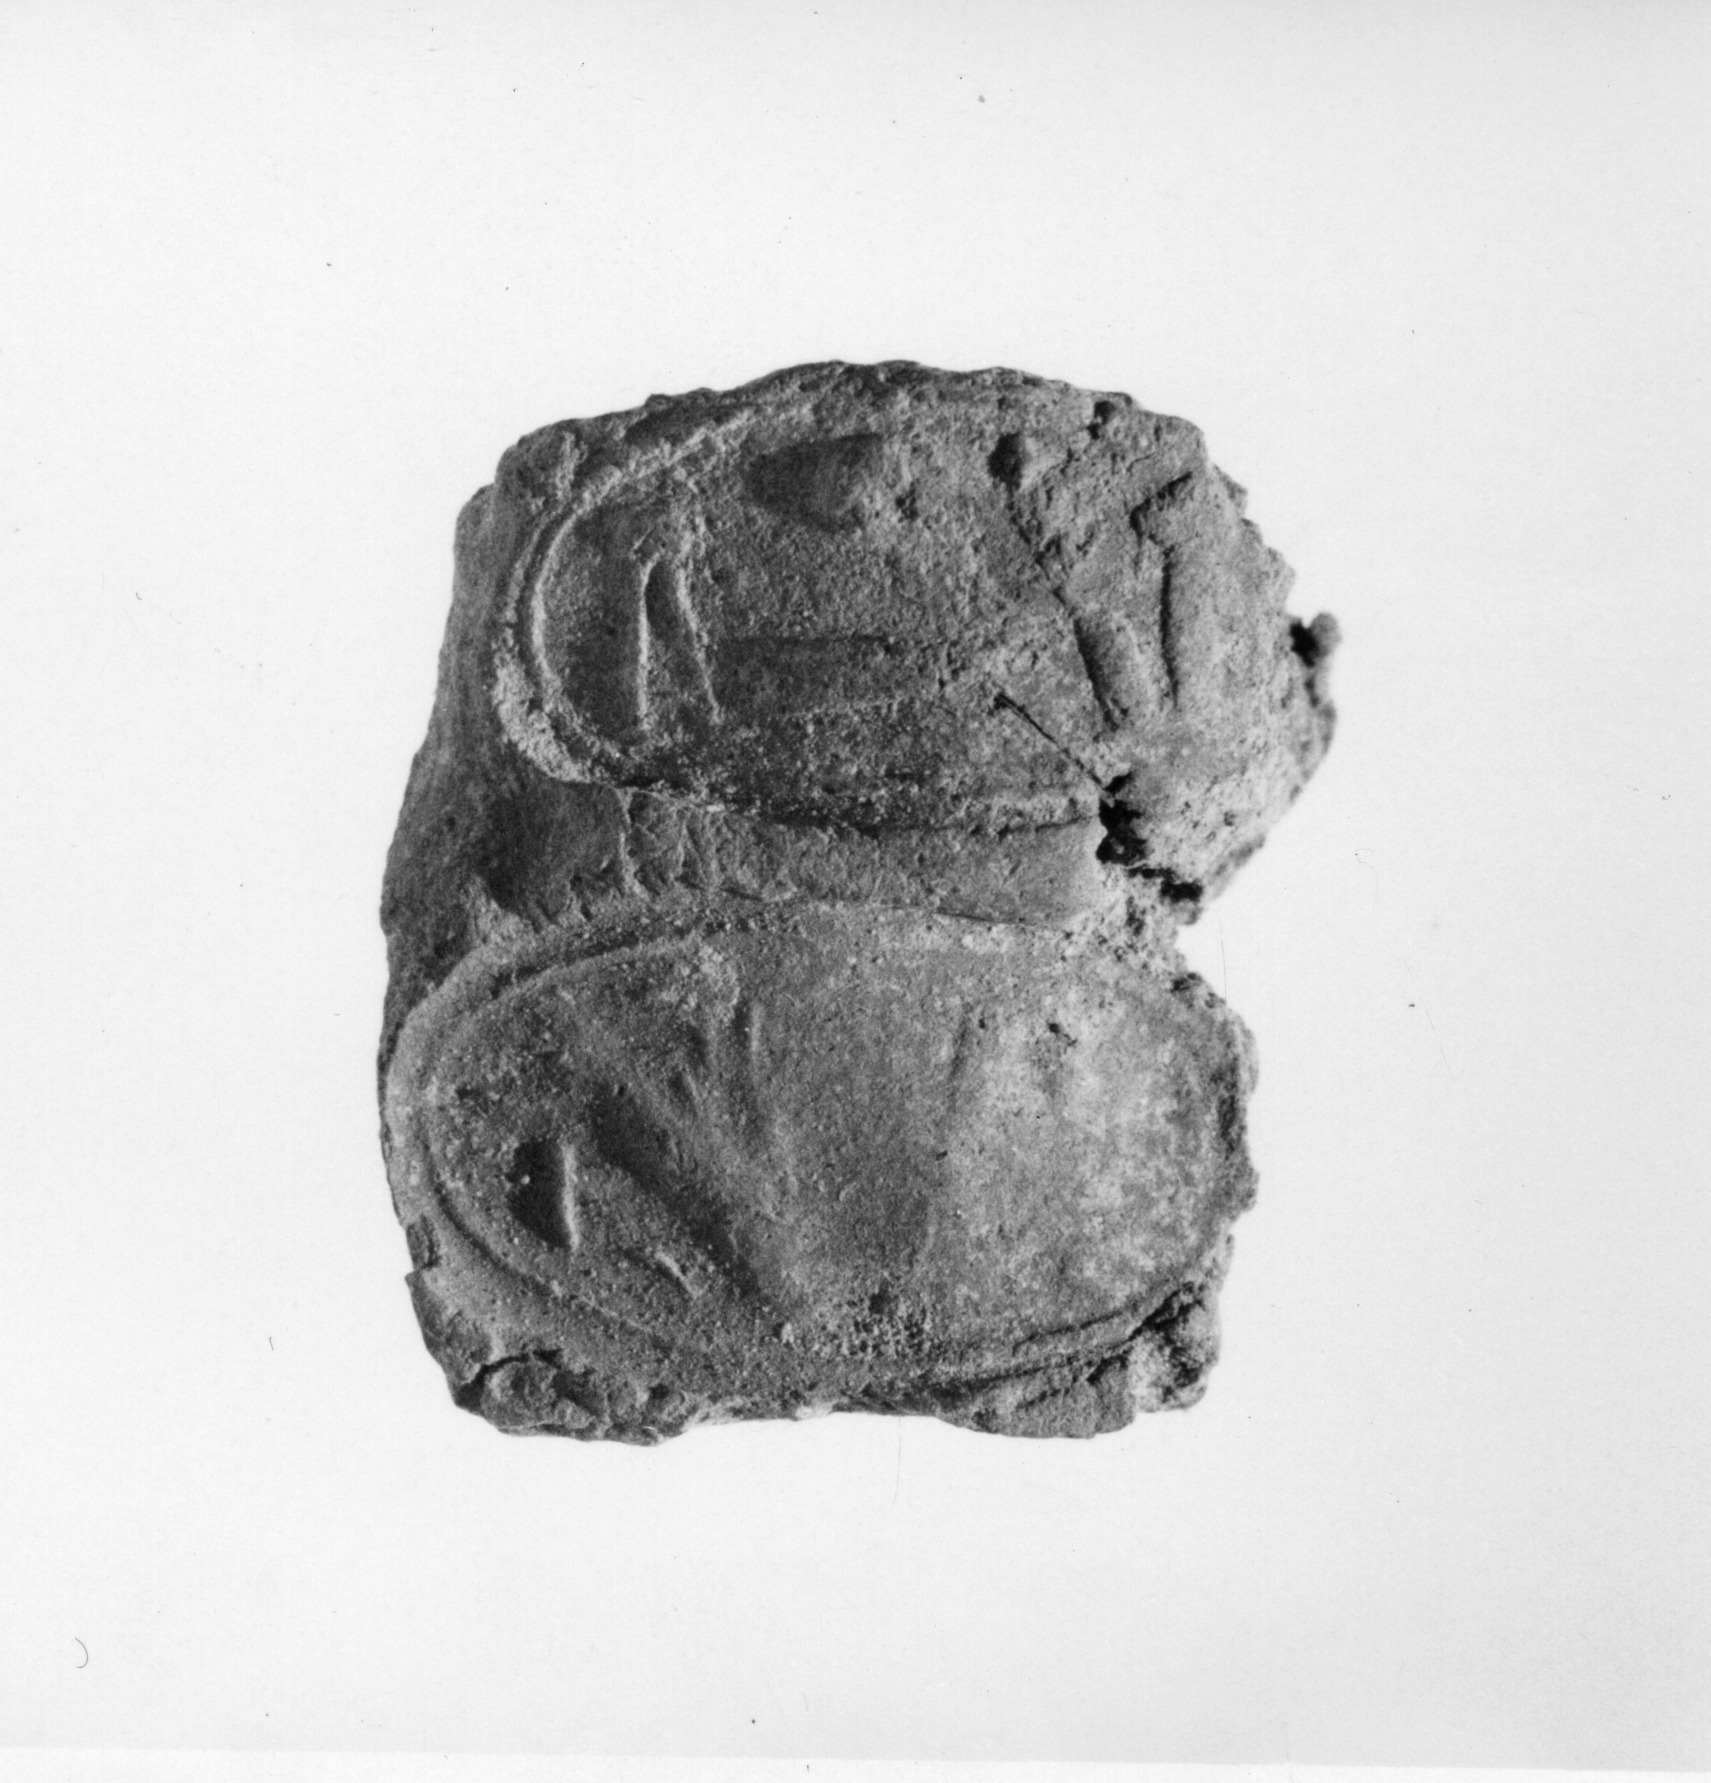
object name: sealing, nebmaatre, amenhotep iii,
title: Document Sealing With Multiple Seal Impressions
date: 1390-1352 BCE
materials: mud